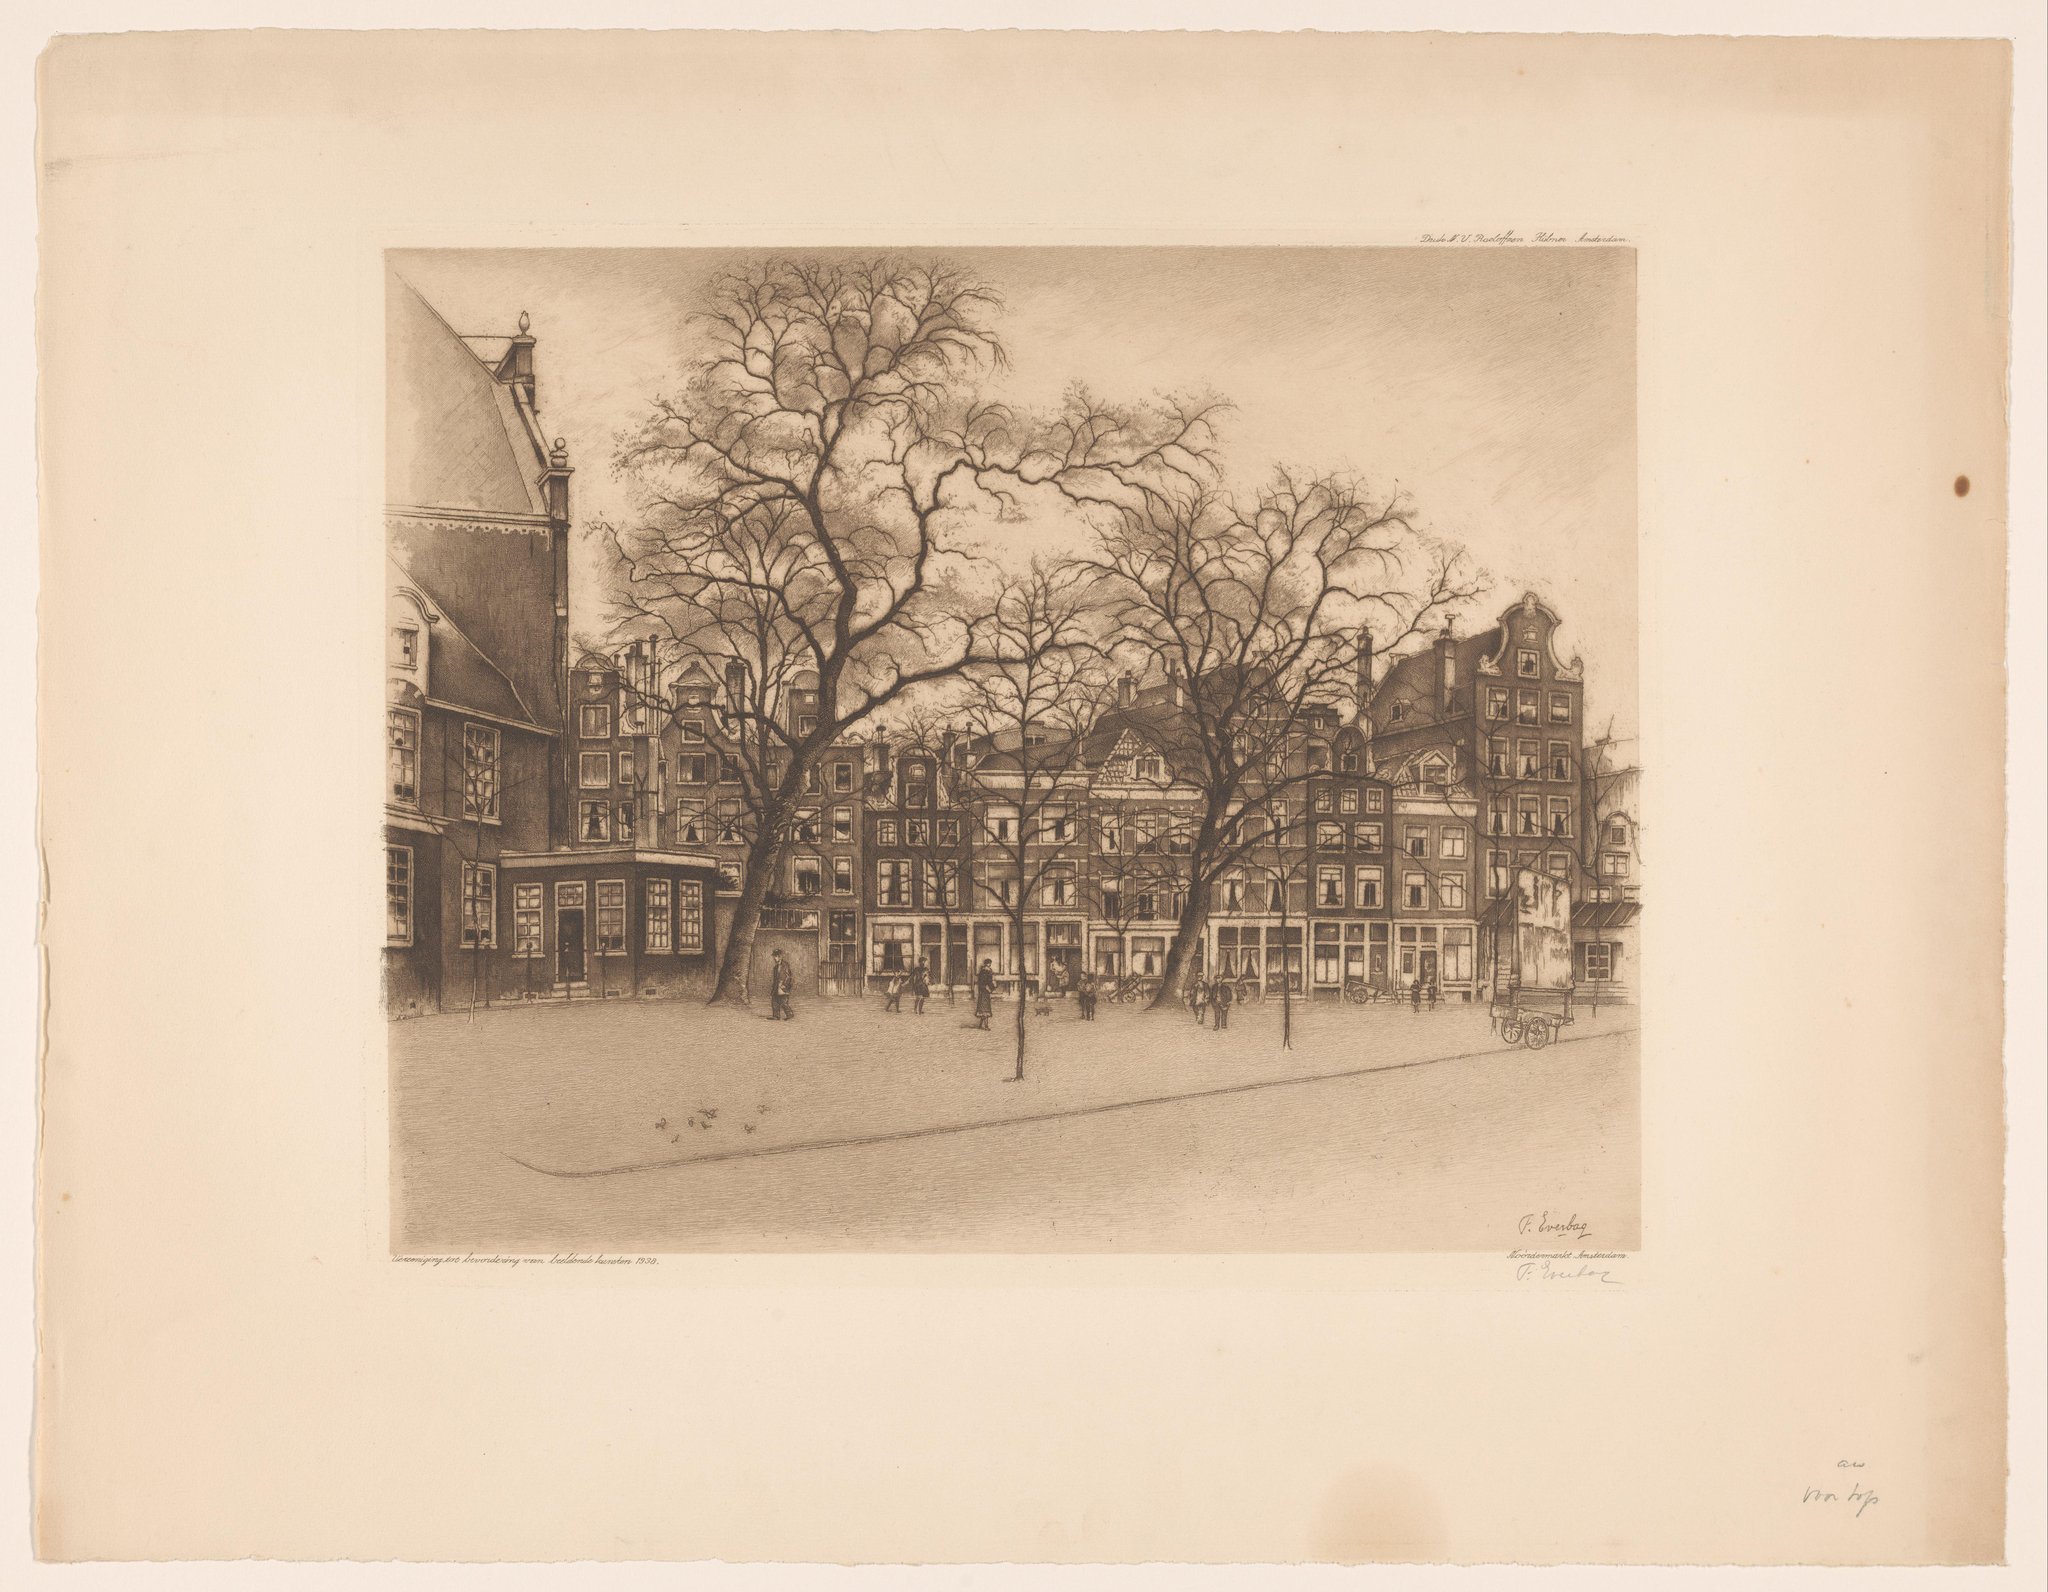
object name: print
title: Gezicht op de Noordermarkt in Amsterdam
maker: frans everbag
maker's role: draughtsman, print maker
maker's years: 1877-1947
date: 1938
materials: paper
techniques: drypoint, etching, intaglio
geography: amsterdam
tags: city-view, and landscape with man-made constructions, trees, housing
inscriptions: watermark, inscription: ‘aw voor [...]p’, collector's mark: Lugt 2228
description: Links onder de voorstelling staat gedrukt: Vereeniging tot bevordering van beeldende kunsten 1938.